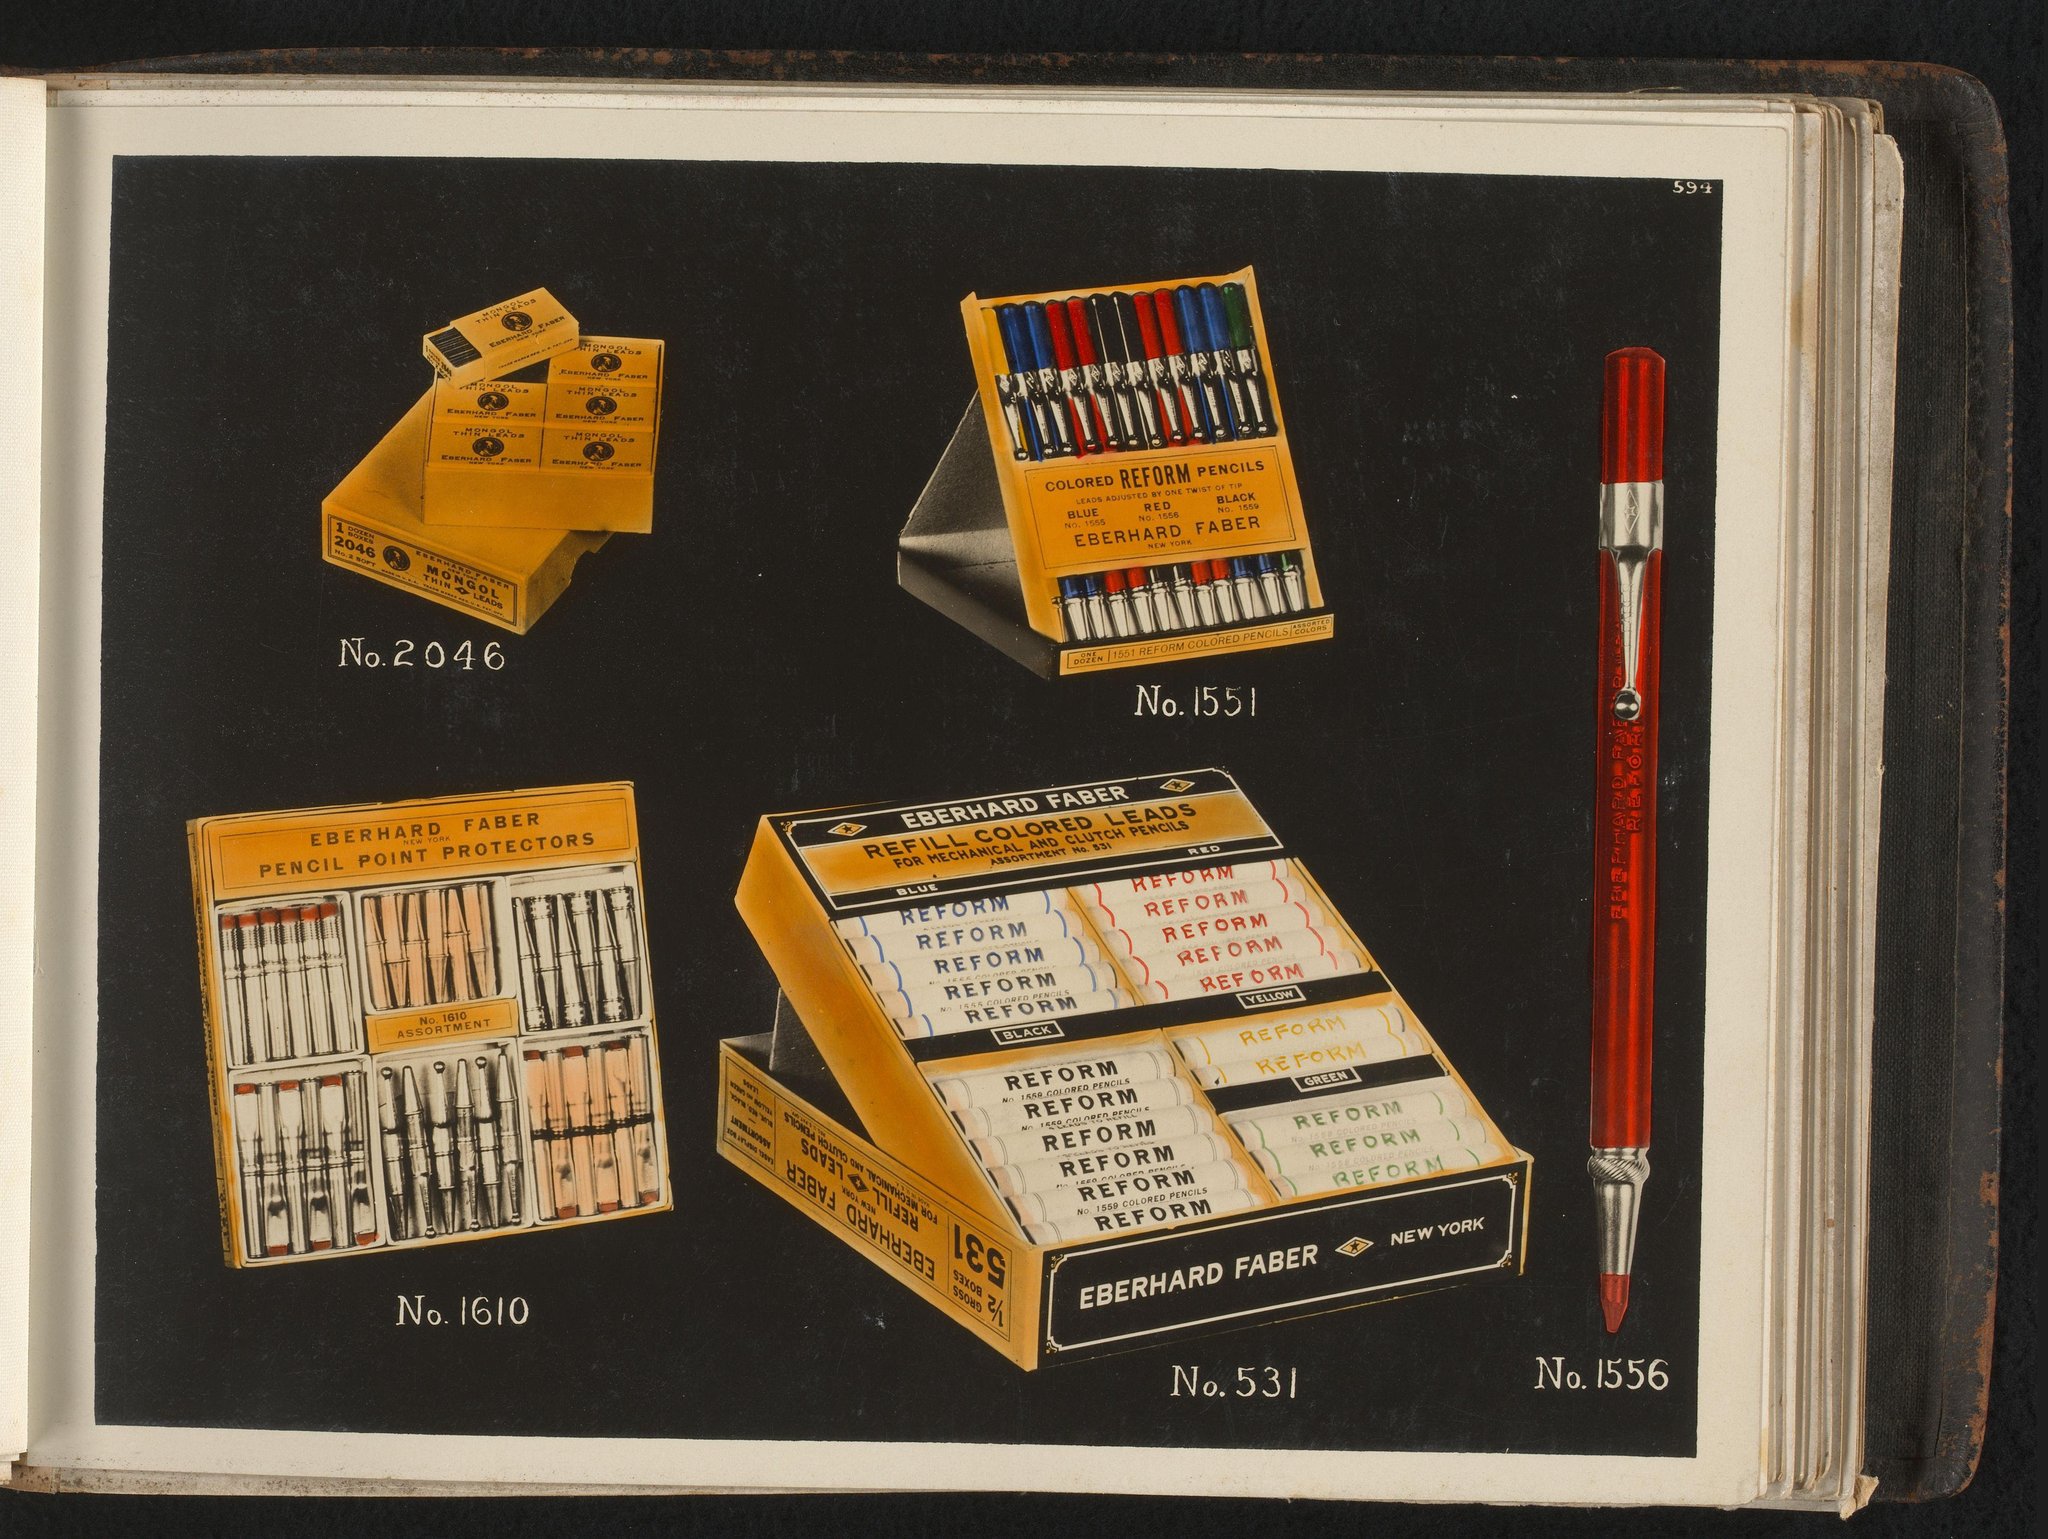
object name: photograph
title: Standaarden met schrijfwaren van Eberhard Faber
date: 1915-1935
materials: paper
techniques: gelatin silver print, hand coloring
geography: springfield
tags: writing tools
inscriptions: stamp: ‘Paramount/ Commercial Studios/ 145 Chestnut St./ Springfield - Mass.’, number: ‘594’